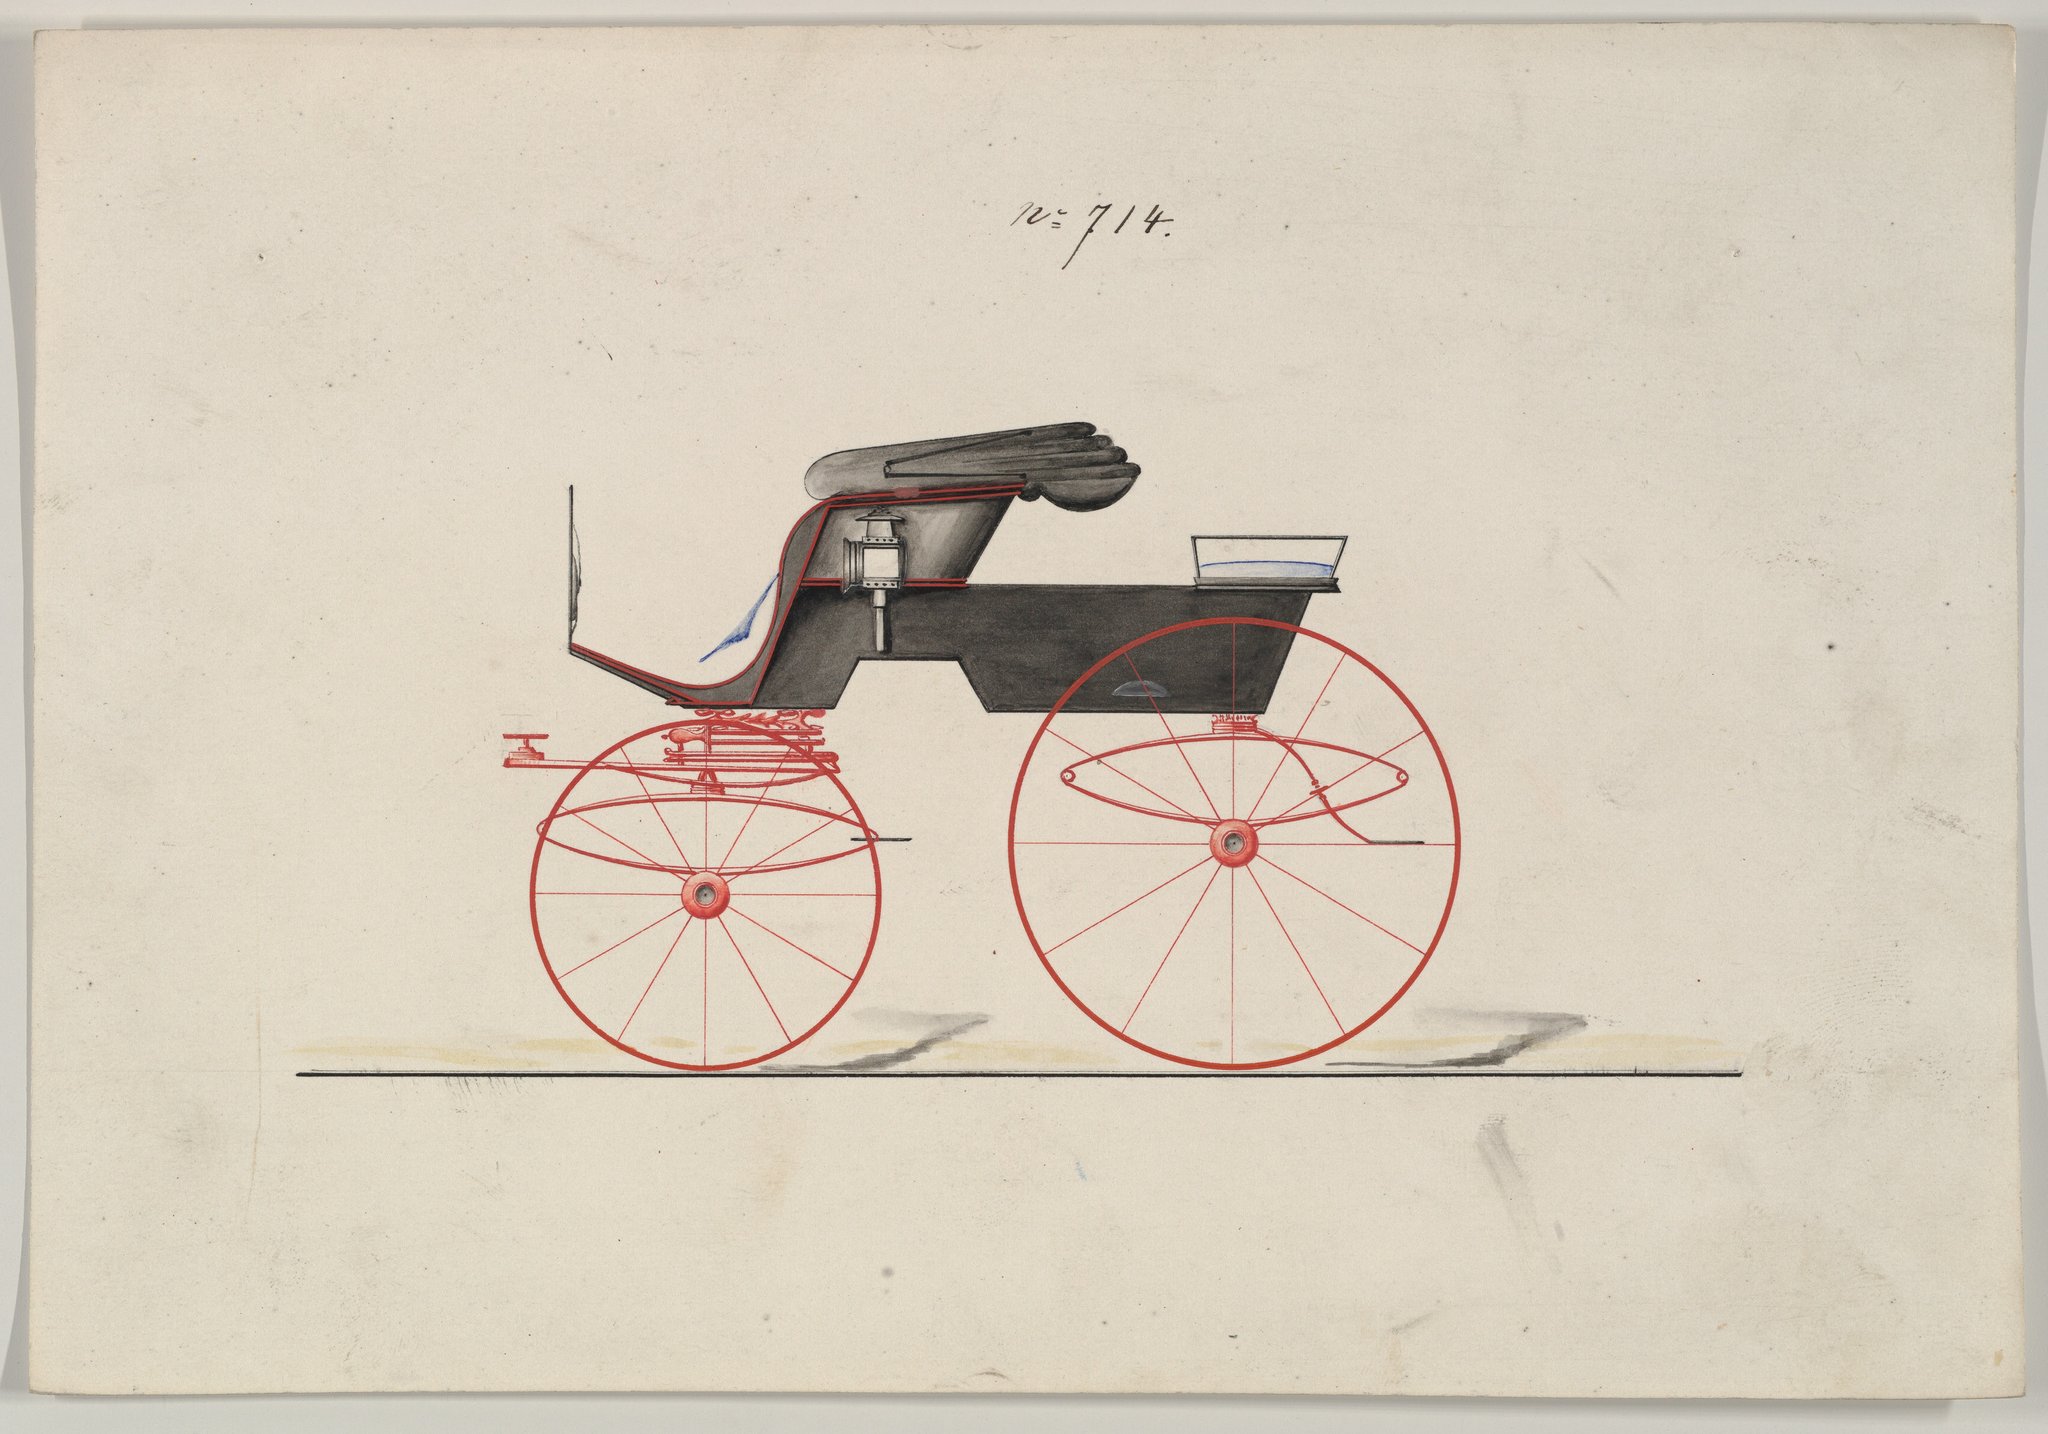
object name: drawing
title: Design for Stanhope Phaeton, no. 714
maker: brewster & co.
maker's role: manufacturer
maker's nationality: american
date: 1850-1874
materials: gouache, ink, watercolor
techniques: pen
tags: carriages